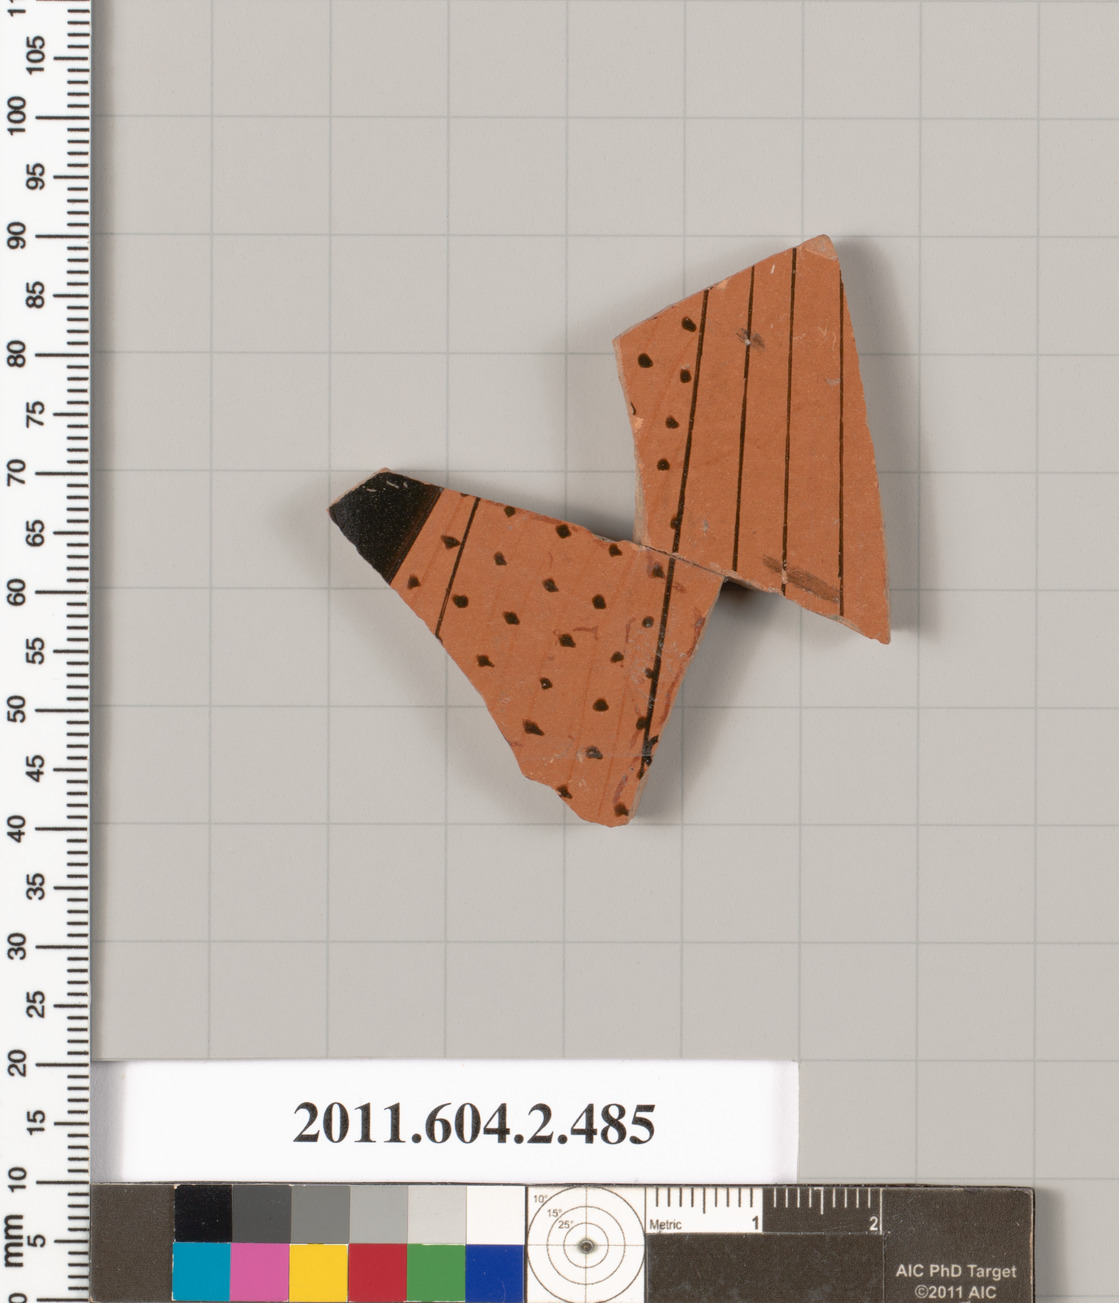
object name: column krater fragment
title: Terracotta fragment of a column-krater (bowl for mixing wine and water)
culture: greek, attic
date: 460-440 BCE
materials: terracotta